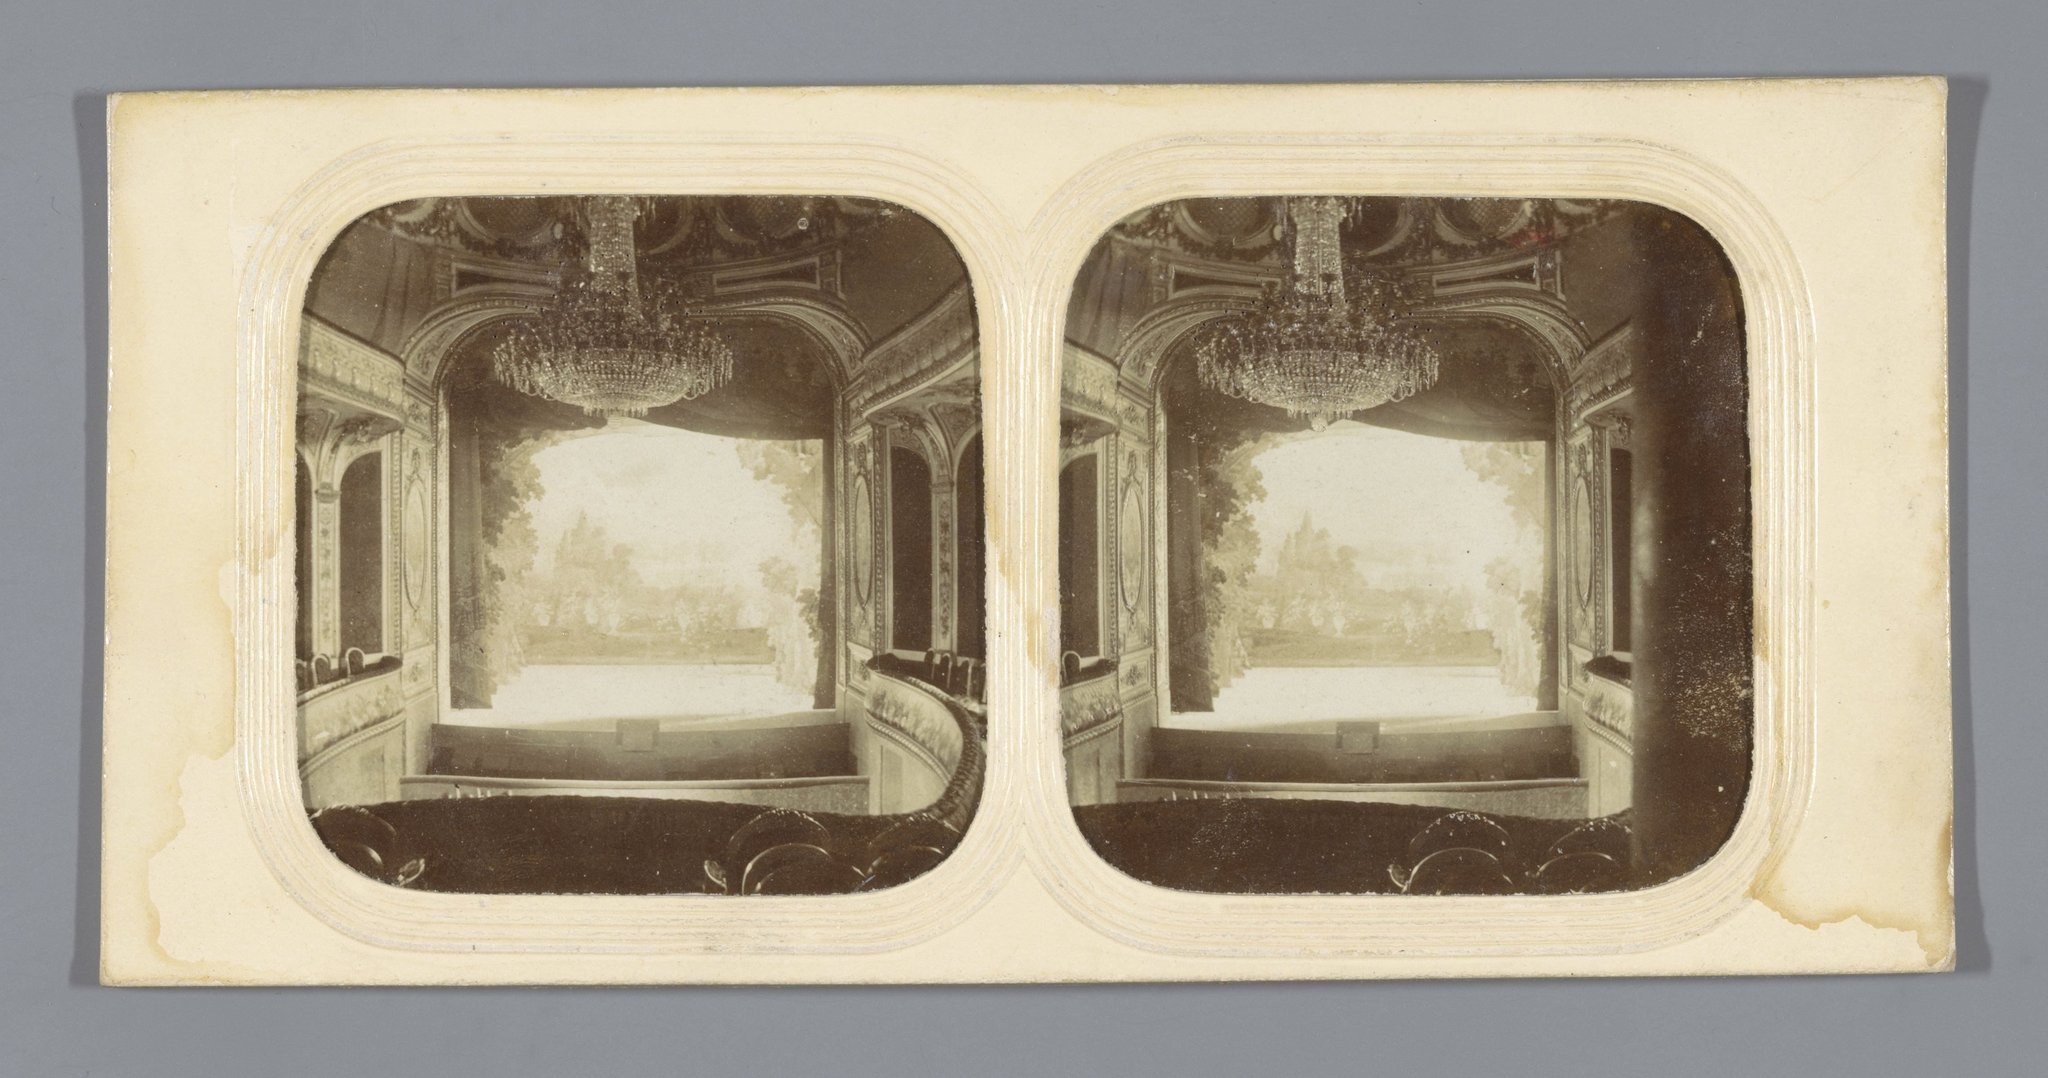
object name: tissue stereograph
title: Résidences impériales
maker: Anonymous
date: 1855-1875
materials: cardboard, paper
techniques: albumen print, hand coloring, perforating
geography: fontainebleau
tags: theatre, theatrical performance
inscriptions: number: ‘11 A.’